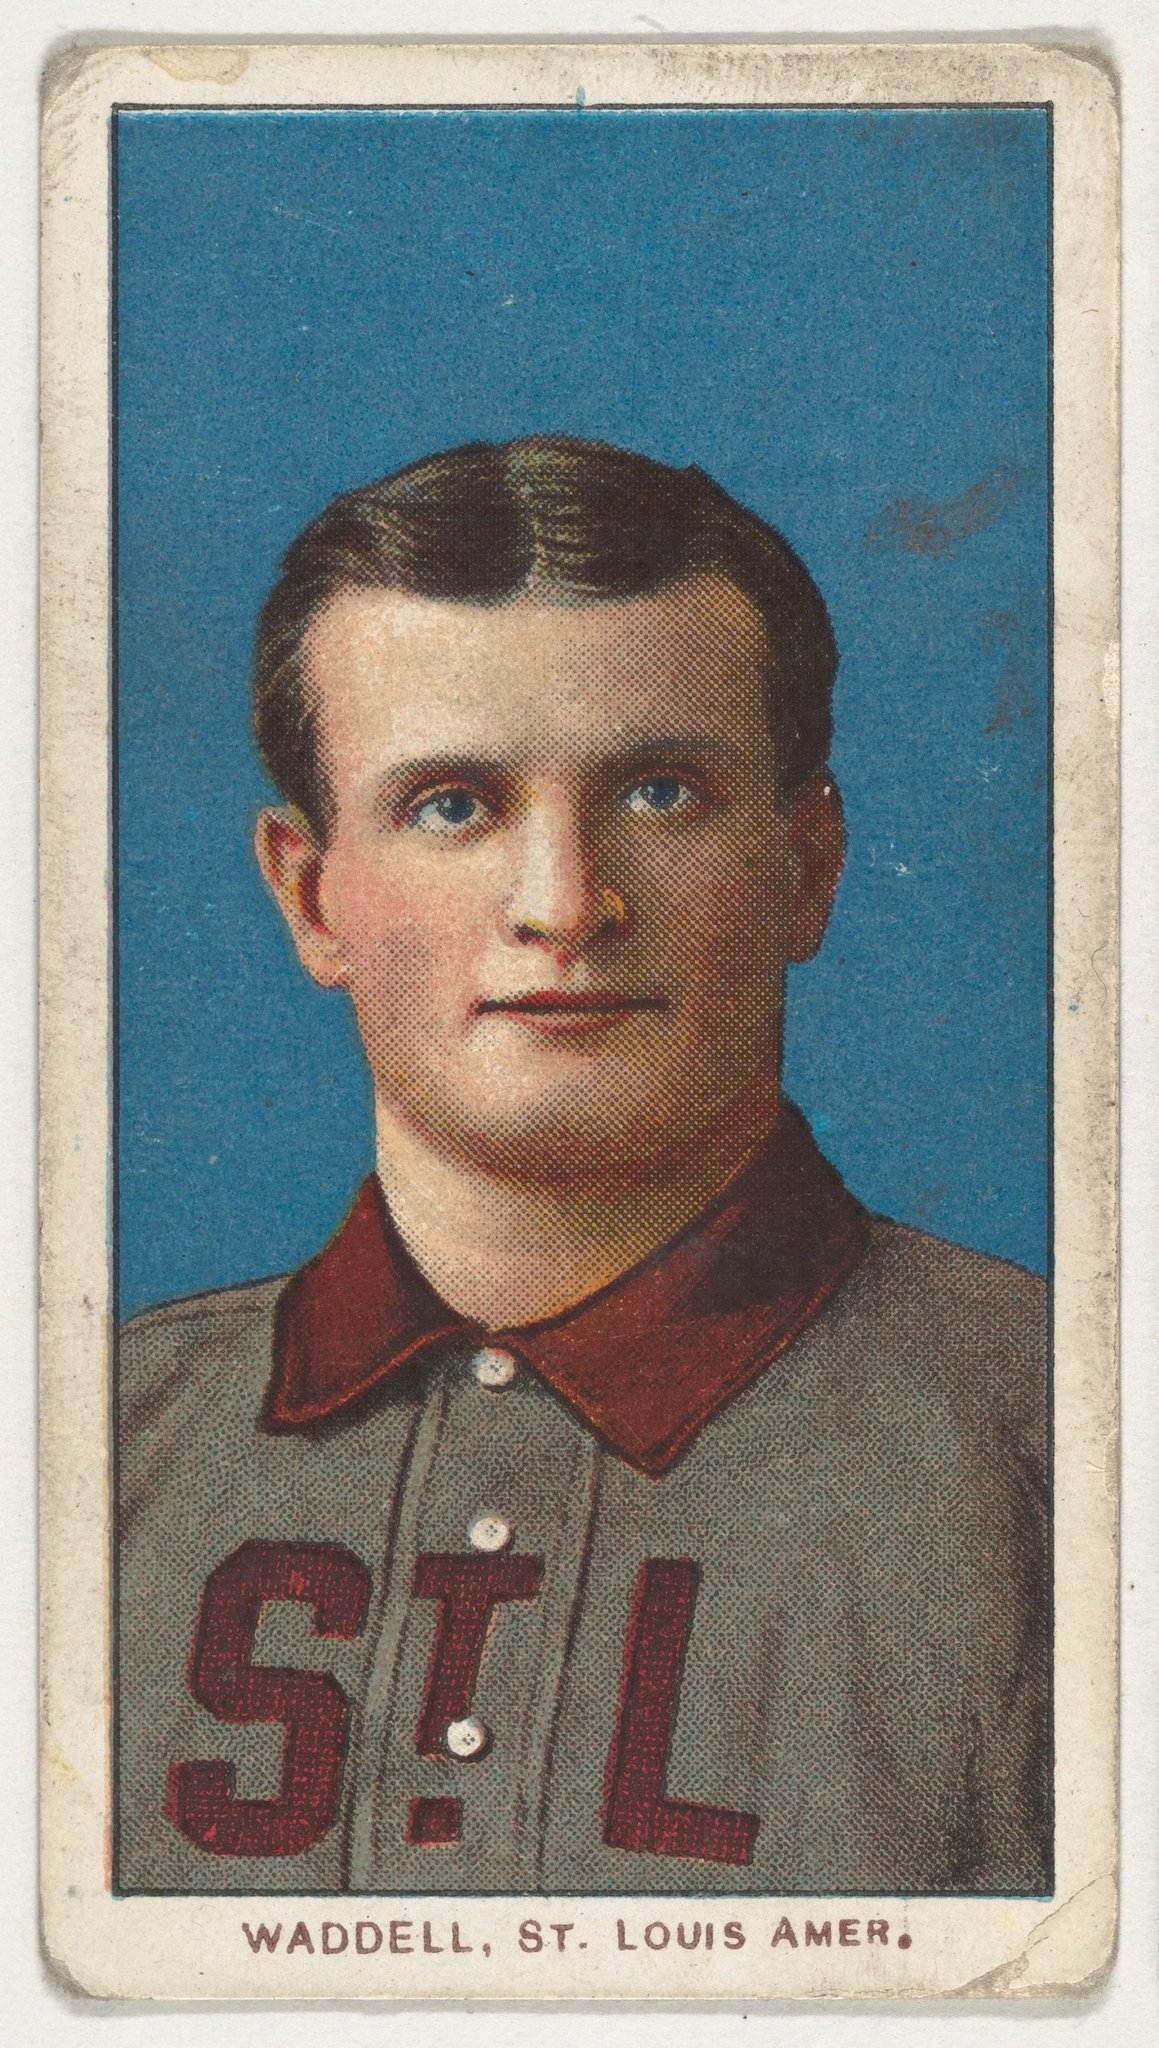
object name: baseball card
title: Waddell, St. Louis, American League, from the White Border series (T206) for the American Tobacco Company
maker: american tobacco company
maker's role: publisher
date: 1909-1911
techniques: lithography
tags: men,portraits,baseball,athletes